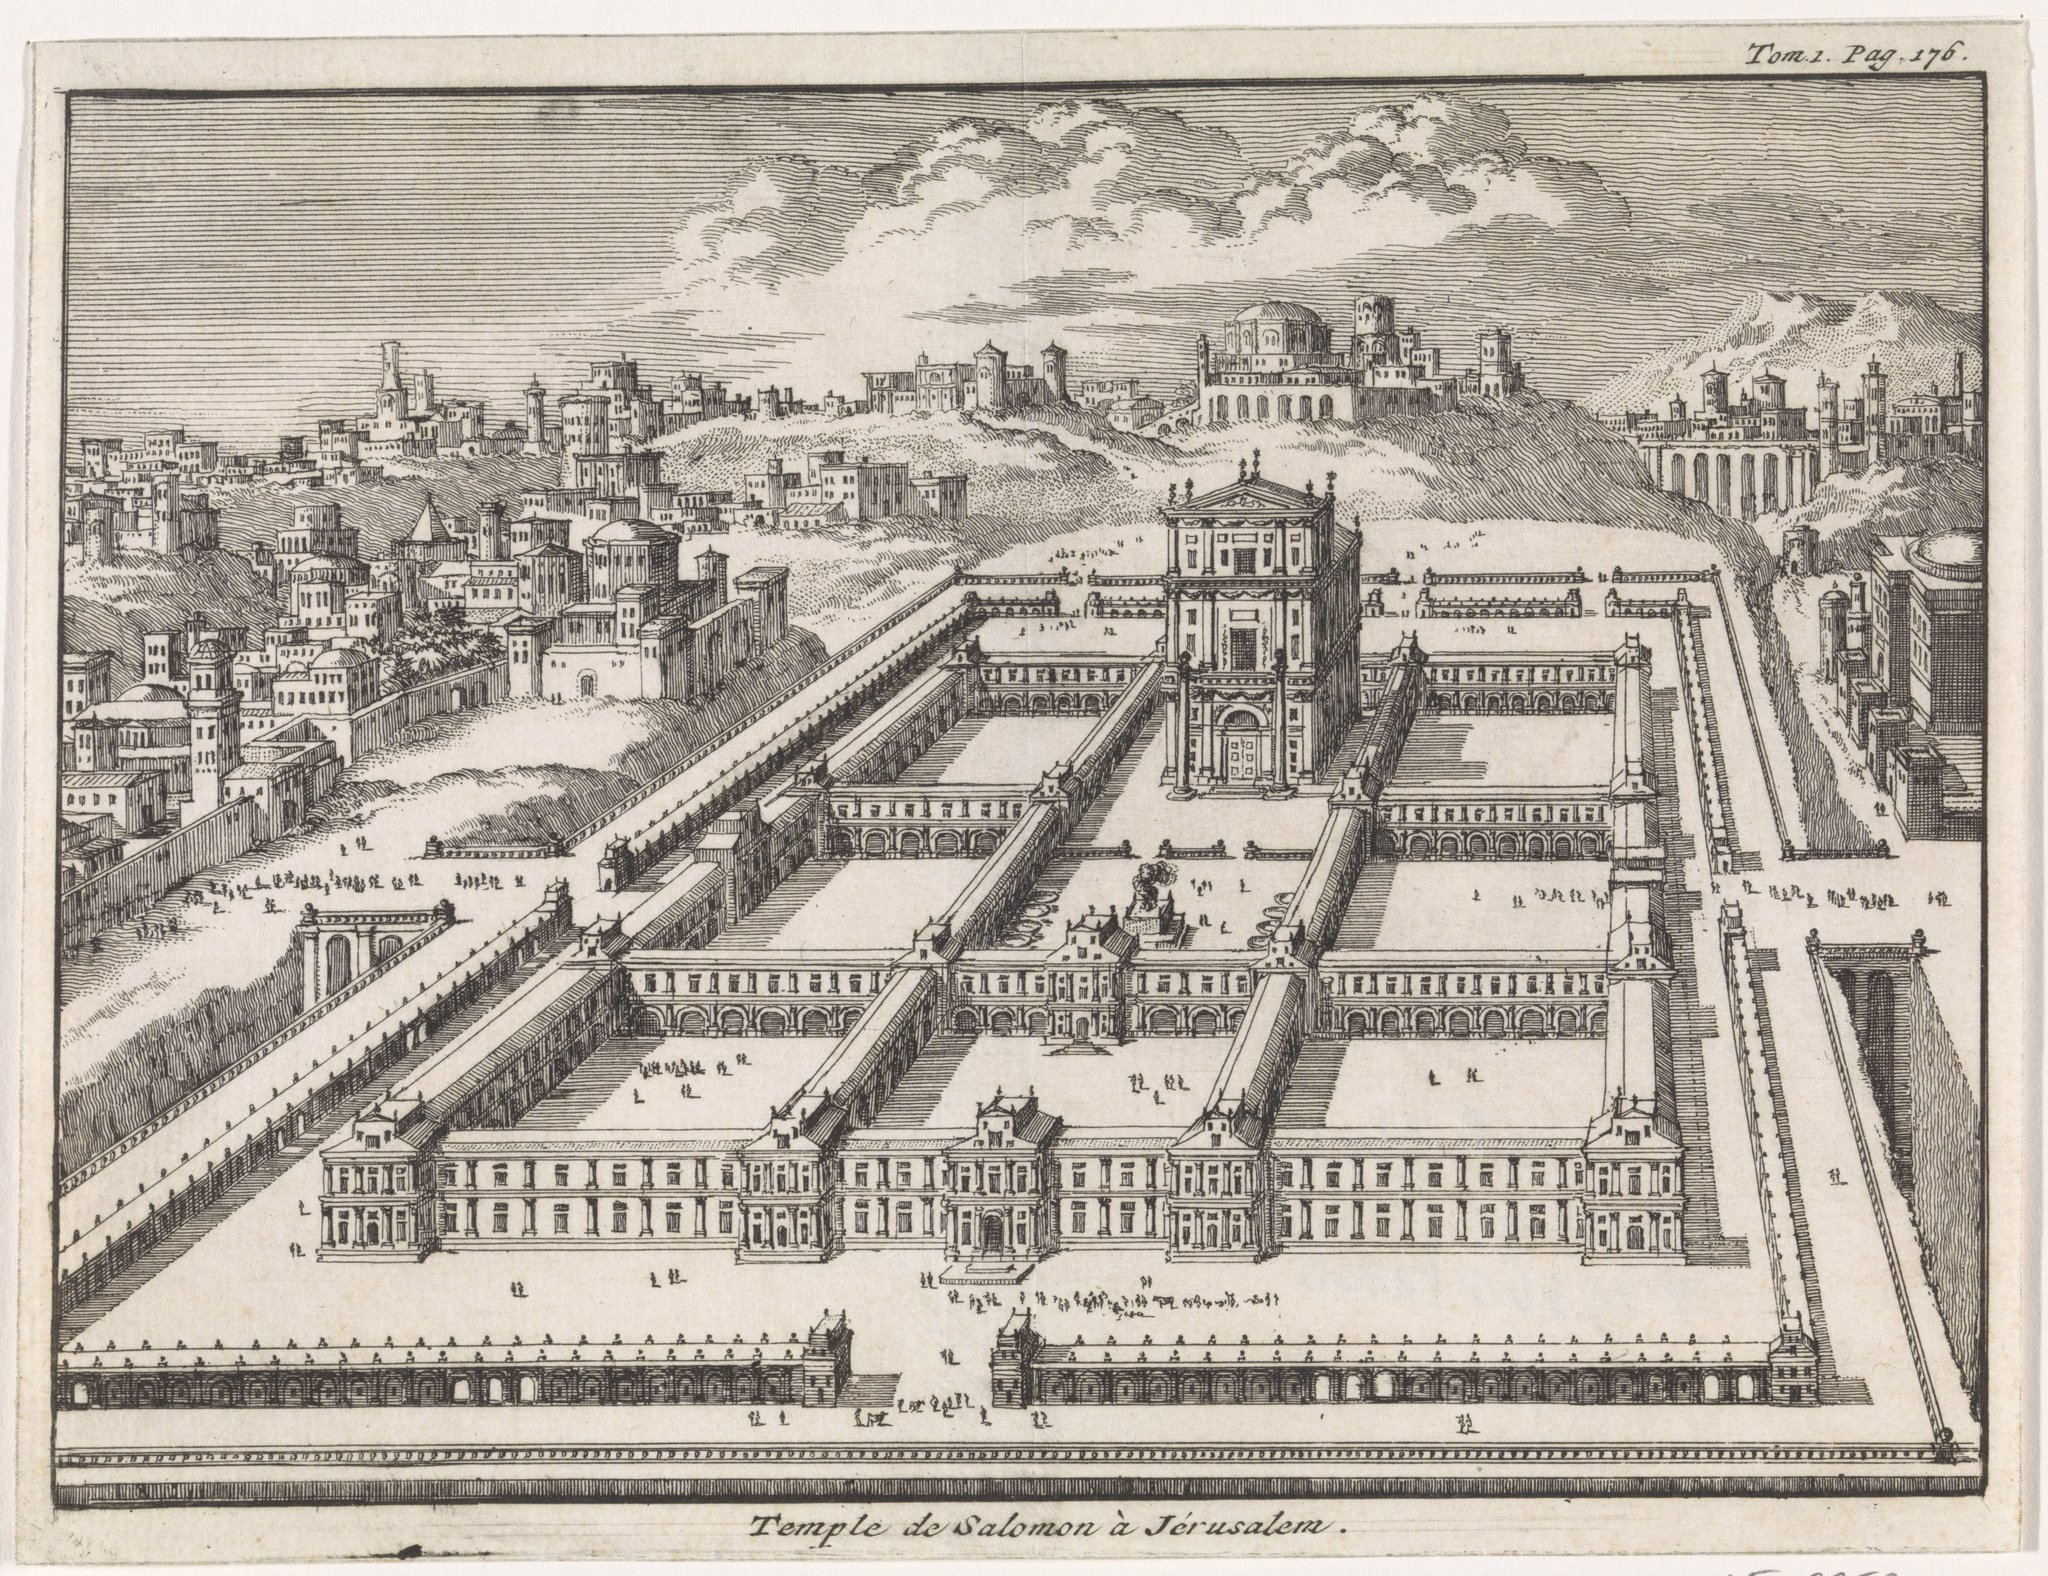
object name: book illustration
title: Temple de Salomon à Jerusalem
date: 1705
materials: paper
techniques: etching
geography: amsterdam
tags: temple of solomon (1 kings 5-9; 2 chronicles 2-7)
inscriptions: collector's mark: Lugt 2228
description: Illustratie uit: Cunaeus, Petrus. La republique des Hebreux, 3 delen. Amsterdam: Pieter Mortier, 1705, dl. I, p. 176.